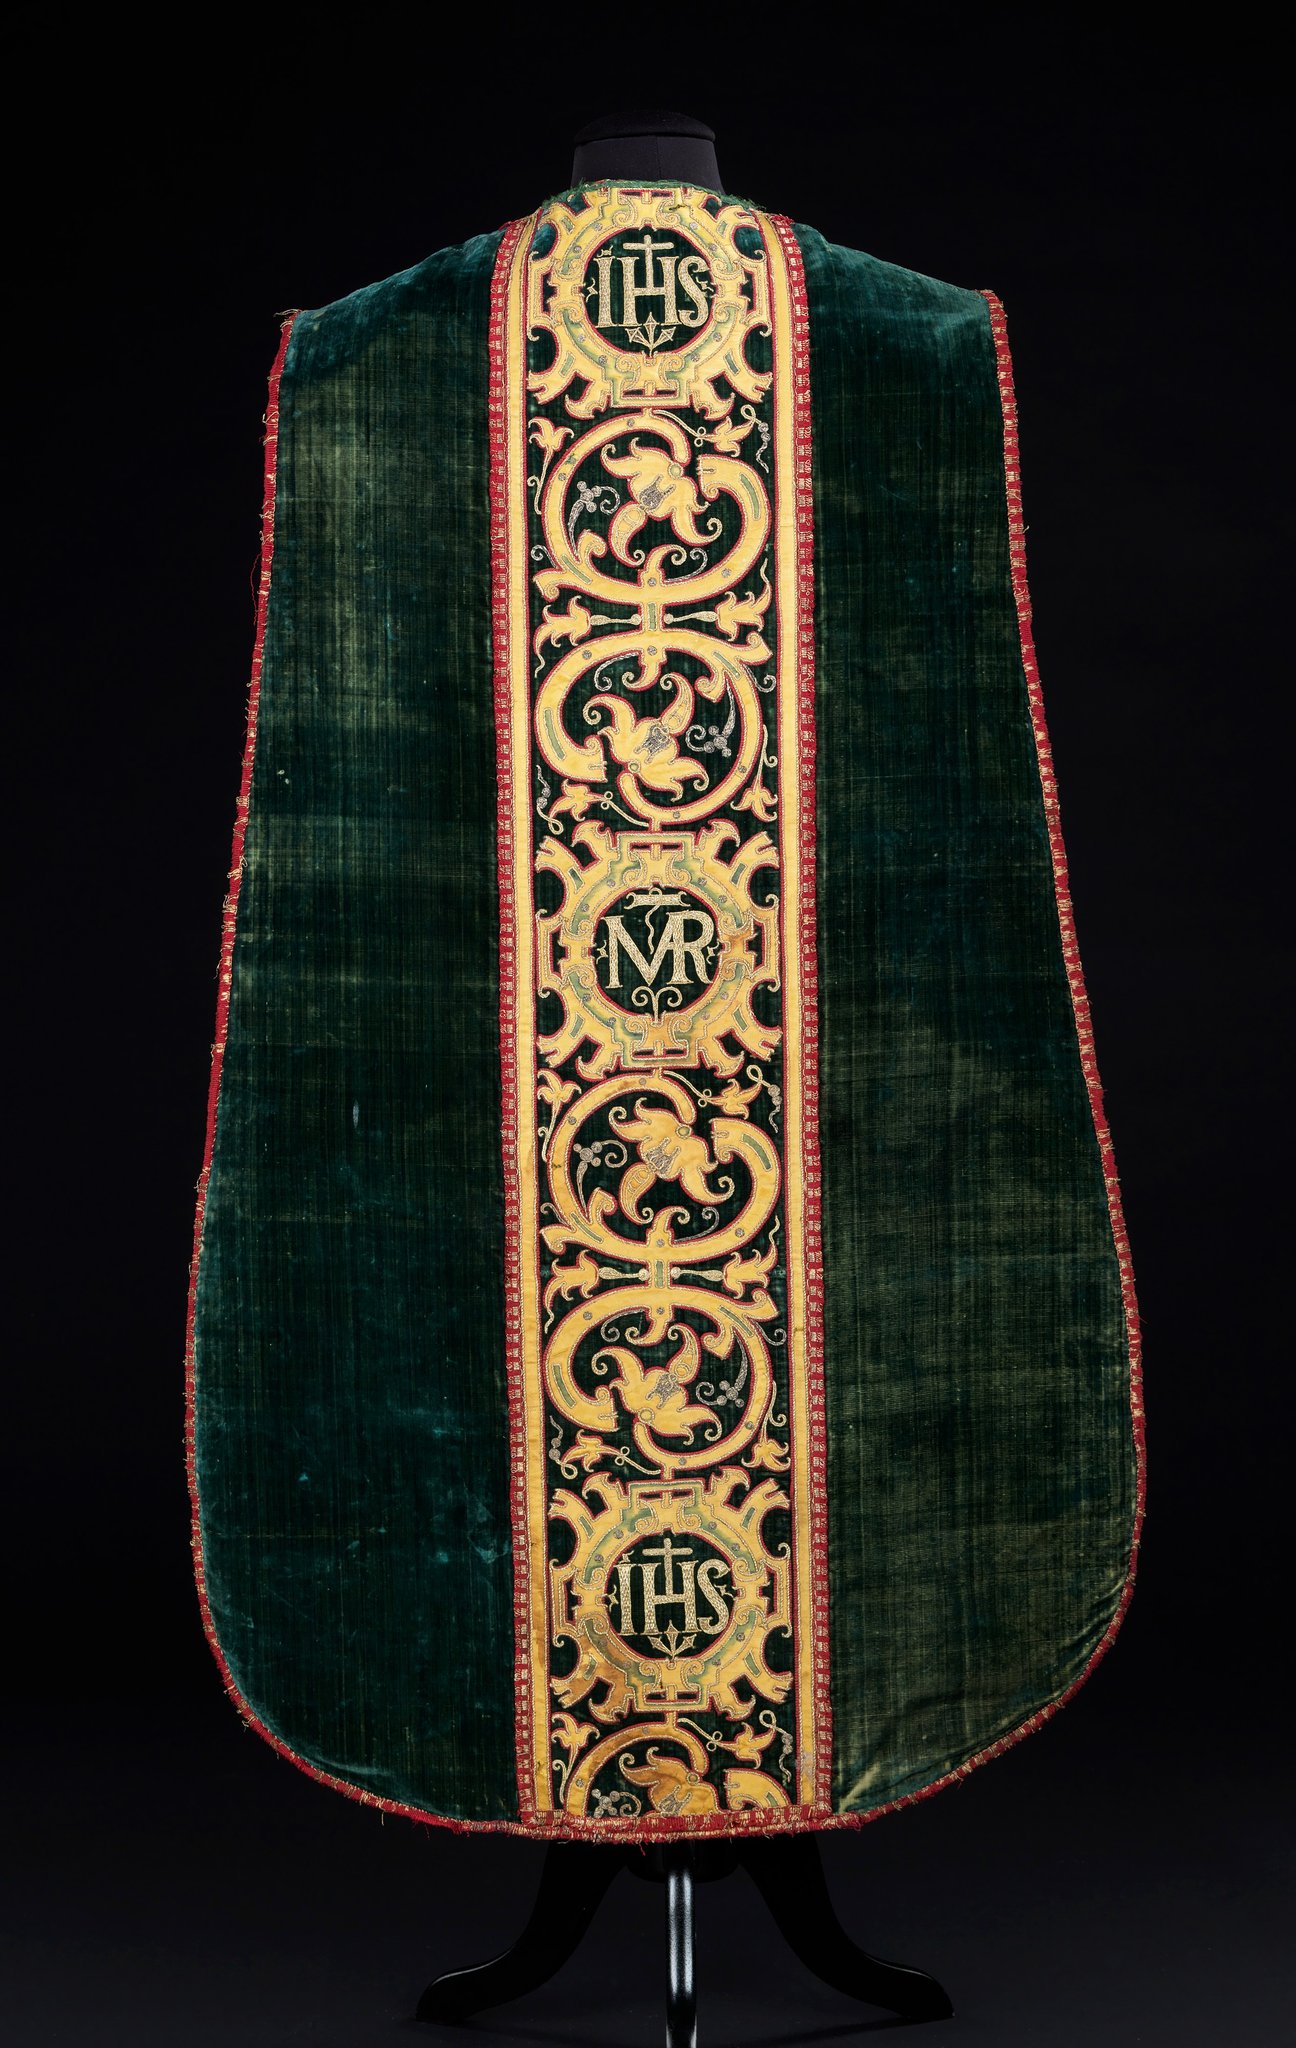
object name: chasuble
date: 1567-1600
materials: metal, silk